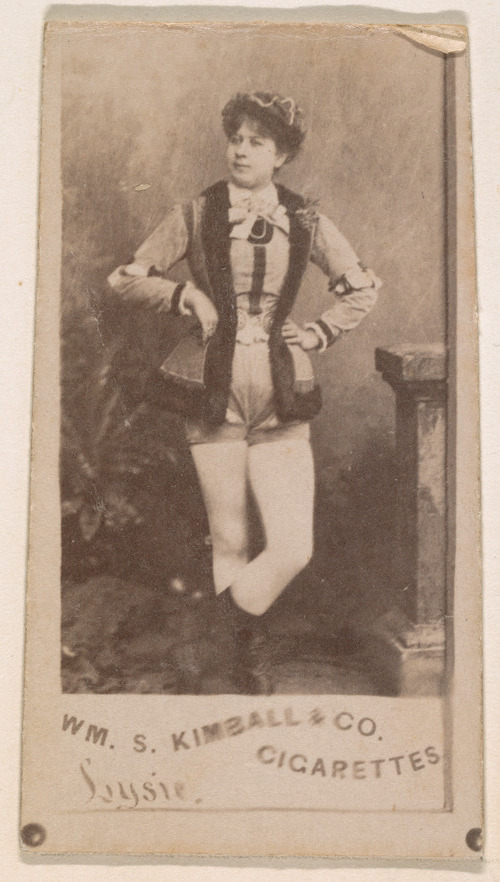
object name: photograph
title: Miss Lysie, from the Actresses series (N203) issued by Wm. S. Kimball & Co.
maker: william s. kimball & company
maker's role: publisher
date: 1889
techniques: color lithograph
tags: portraits,women,actresses